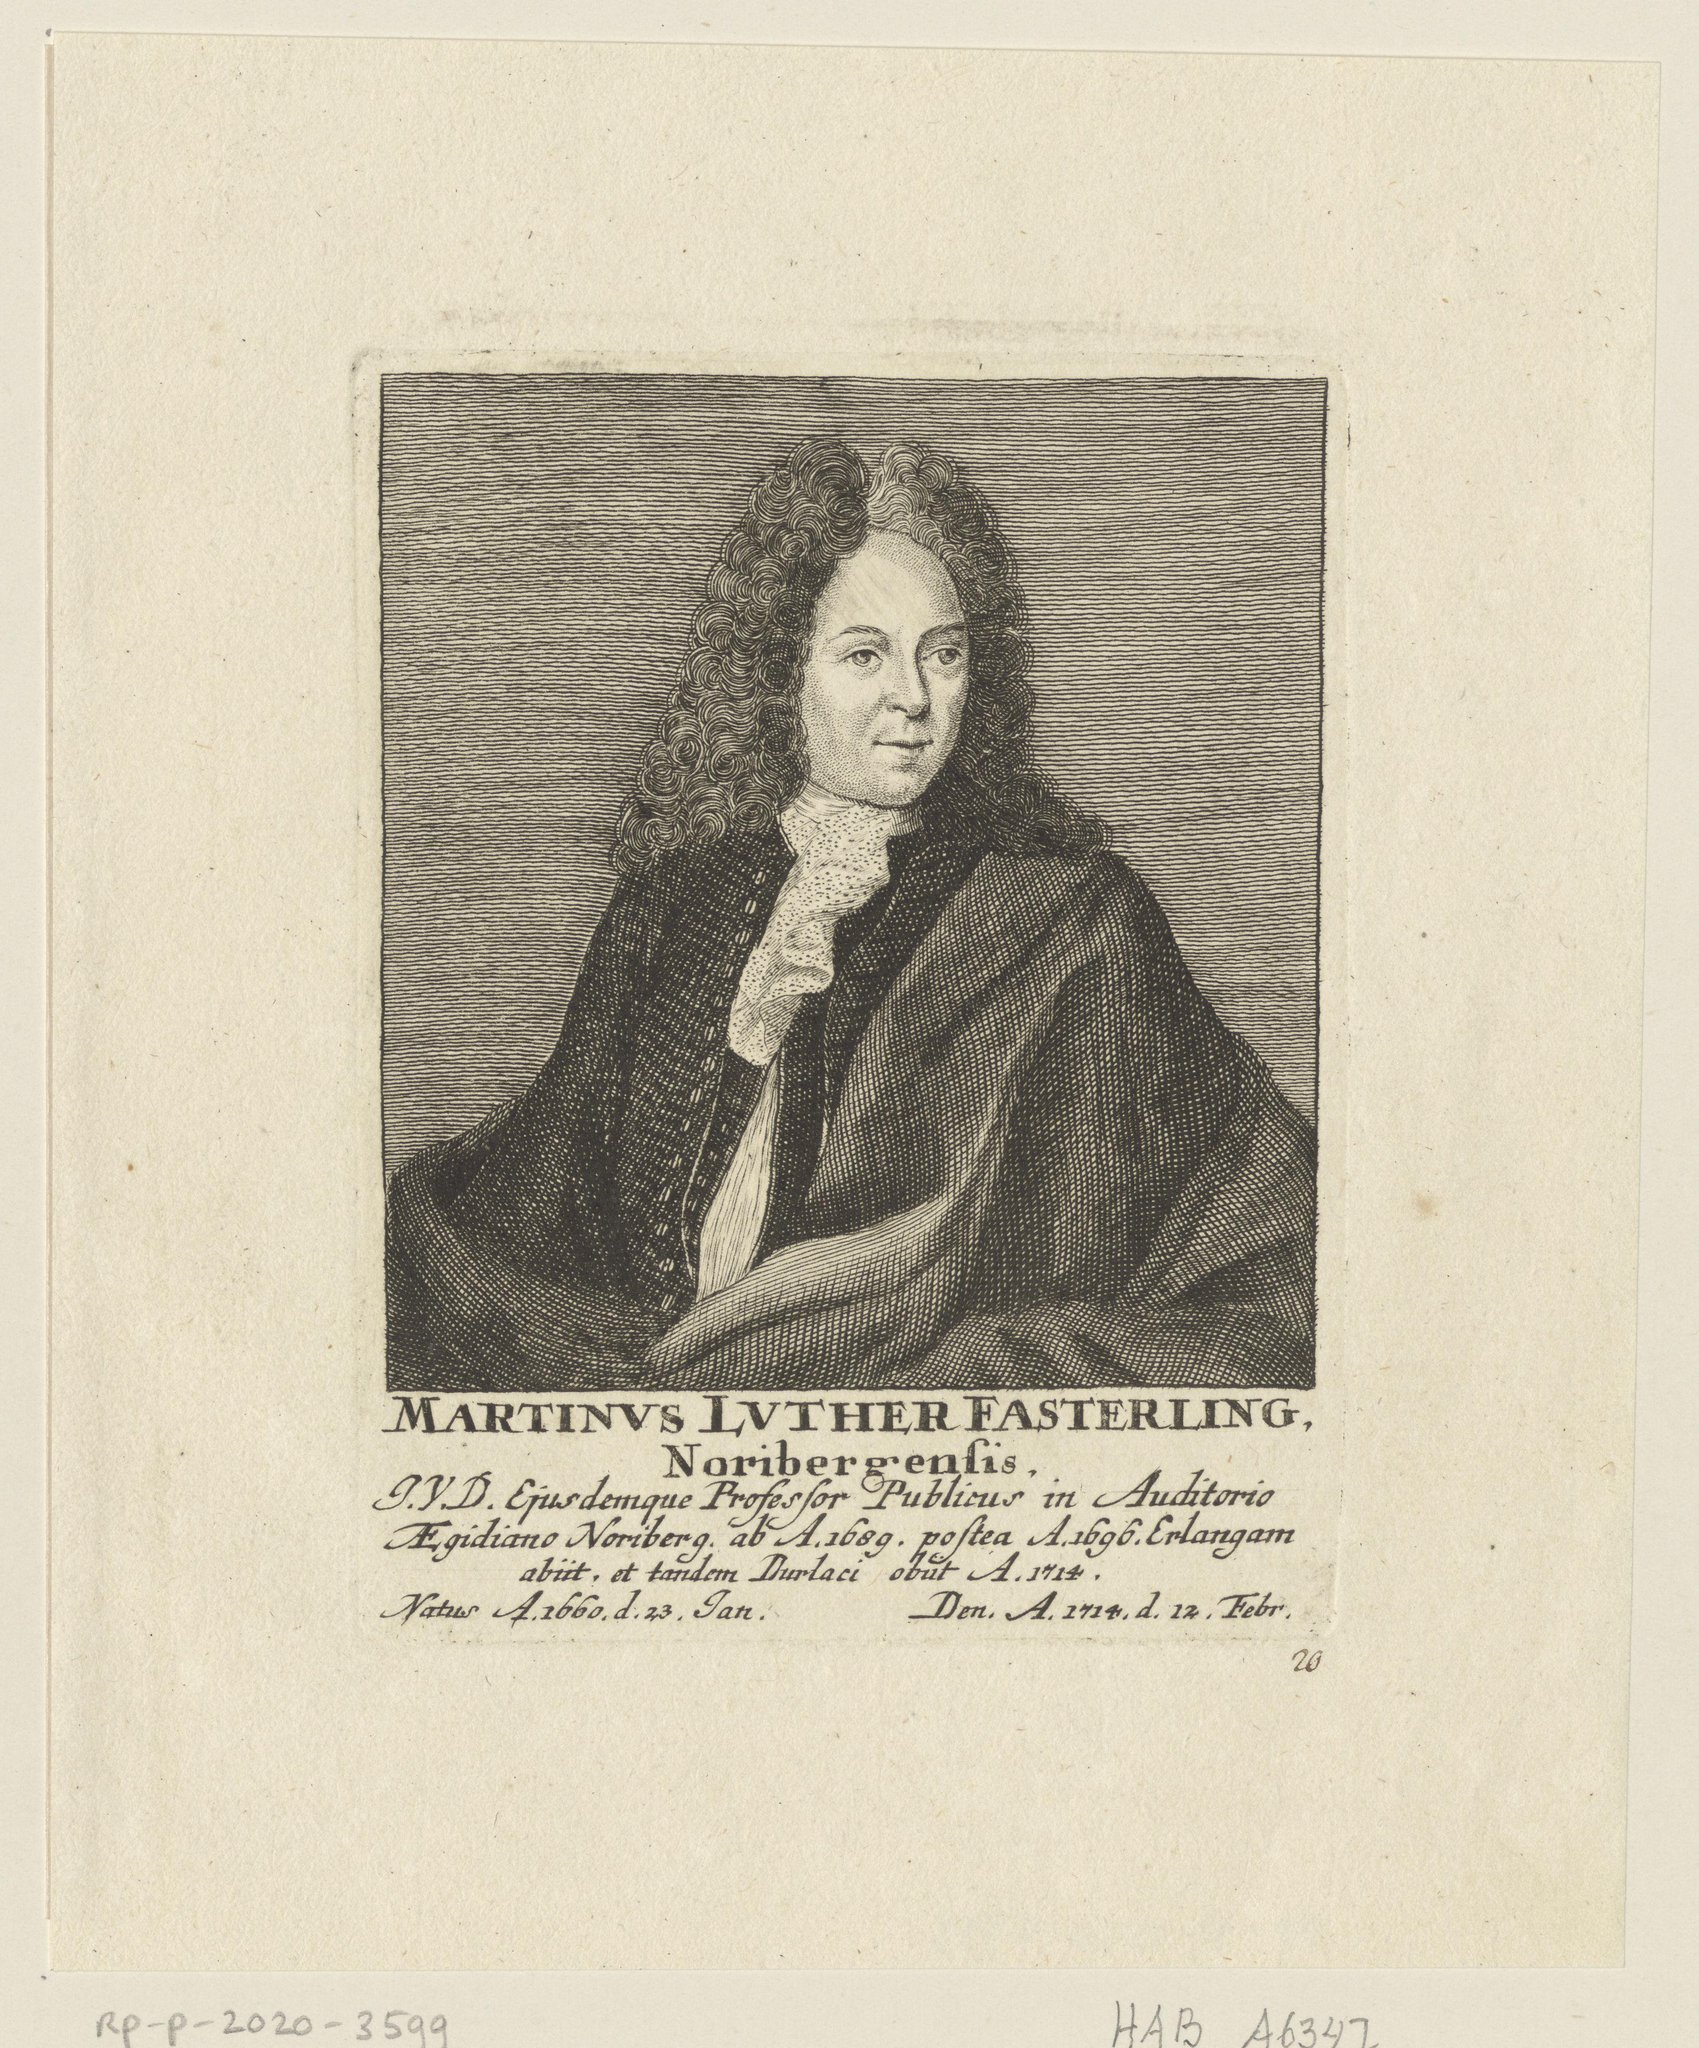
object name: print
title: Portret van Martin Luther Fasterling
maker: Anonymous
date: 1725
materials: paper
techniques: engraving, etching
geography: germany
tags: historical persons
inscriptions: inscription: ‘20’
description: Prent waarschijnlijk uit: Roth-Scholtz, Friedrich. Icones virorum omnium ordinum eruditione omnique item genere (...). Neurenberg: erven Johann Daniel Tauber, 1725.